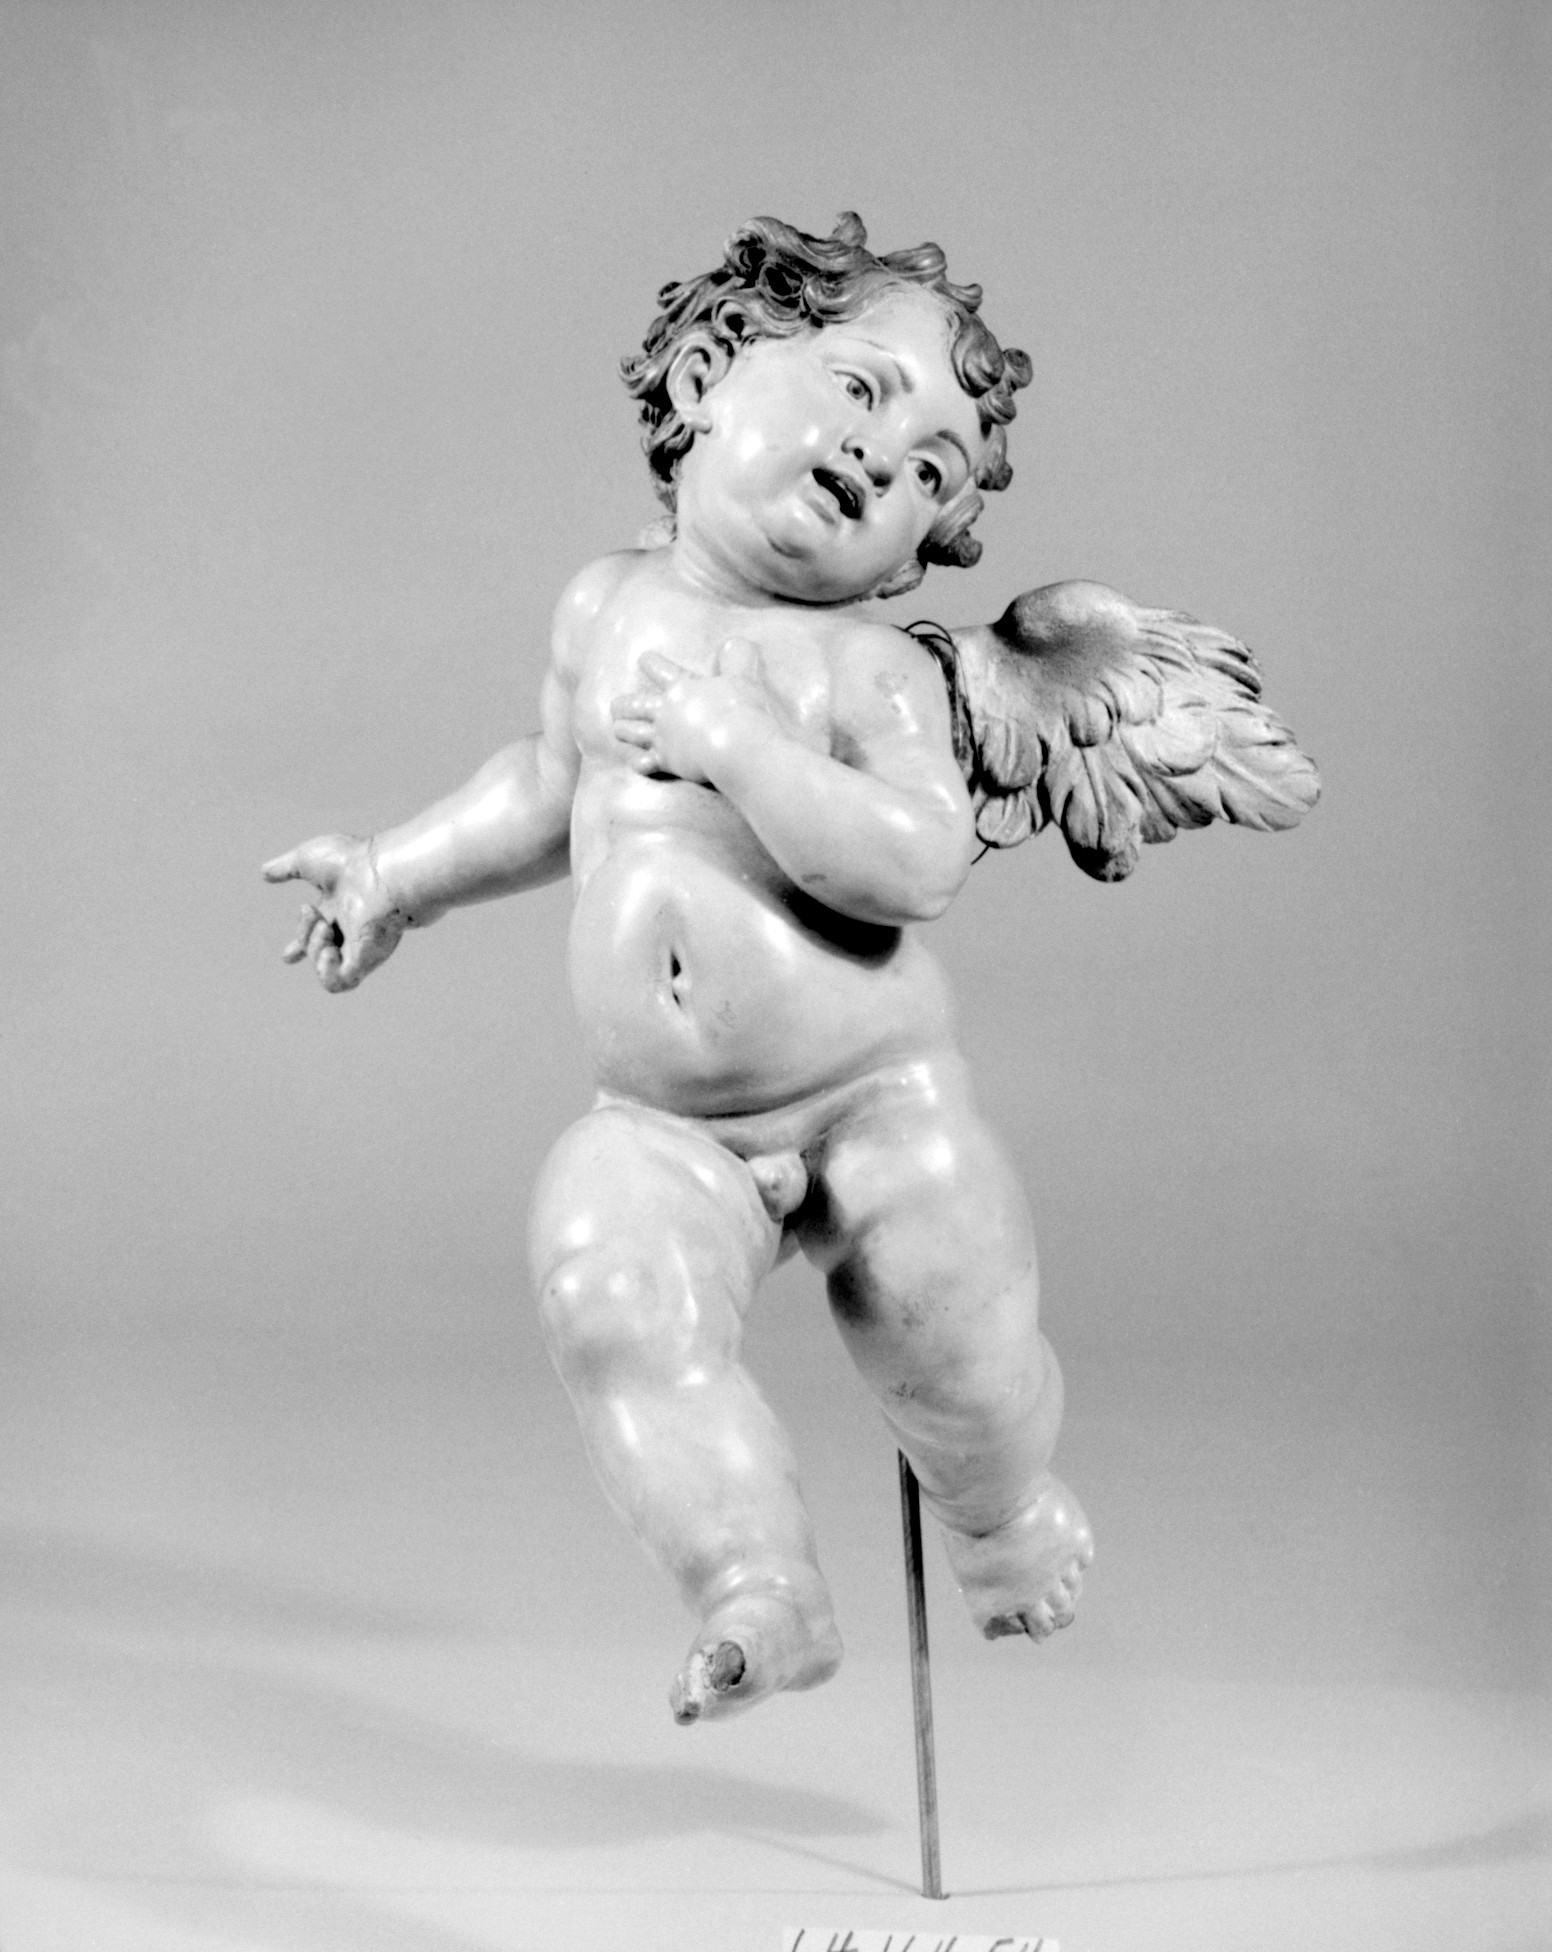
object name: crèche figure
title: Cherub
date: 1751-1800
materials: terracotta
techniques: polychrome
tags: angels